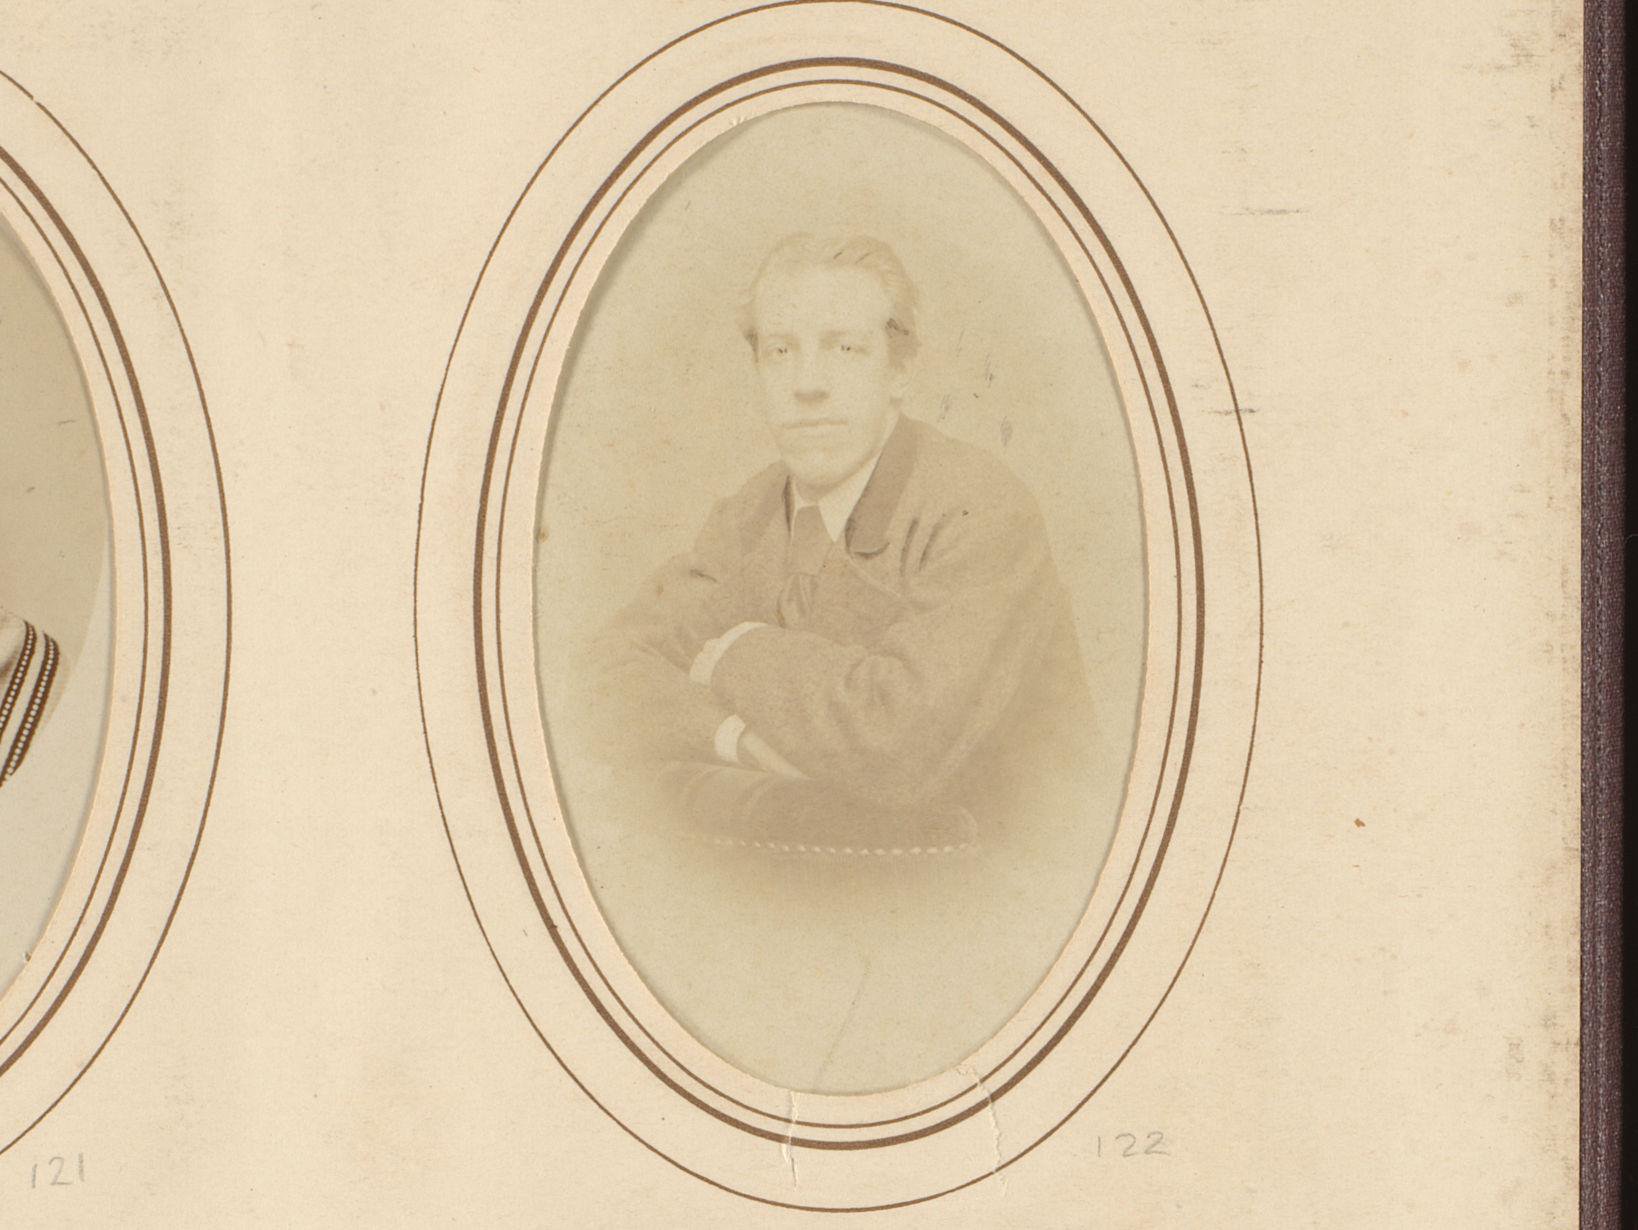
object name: photograph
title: Portret van een man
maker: christaan marcussen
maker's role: fotograaf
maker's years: 1822-1878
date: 1865-1880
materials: cardboard, photographic support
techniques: albumen print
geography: utrecht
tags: adult man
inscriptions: inscription: ‘C. Marcussen/ Kunstschilder en Photograaf/ Utrecht/ Hamburgerstraat naast het Geregtshof.’